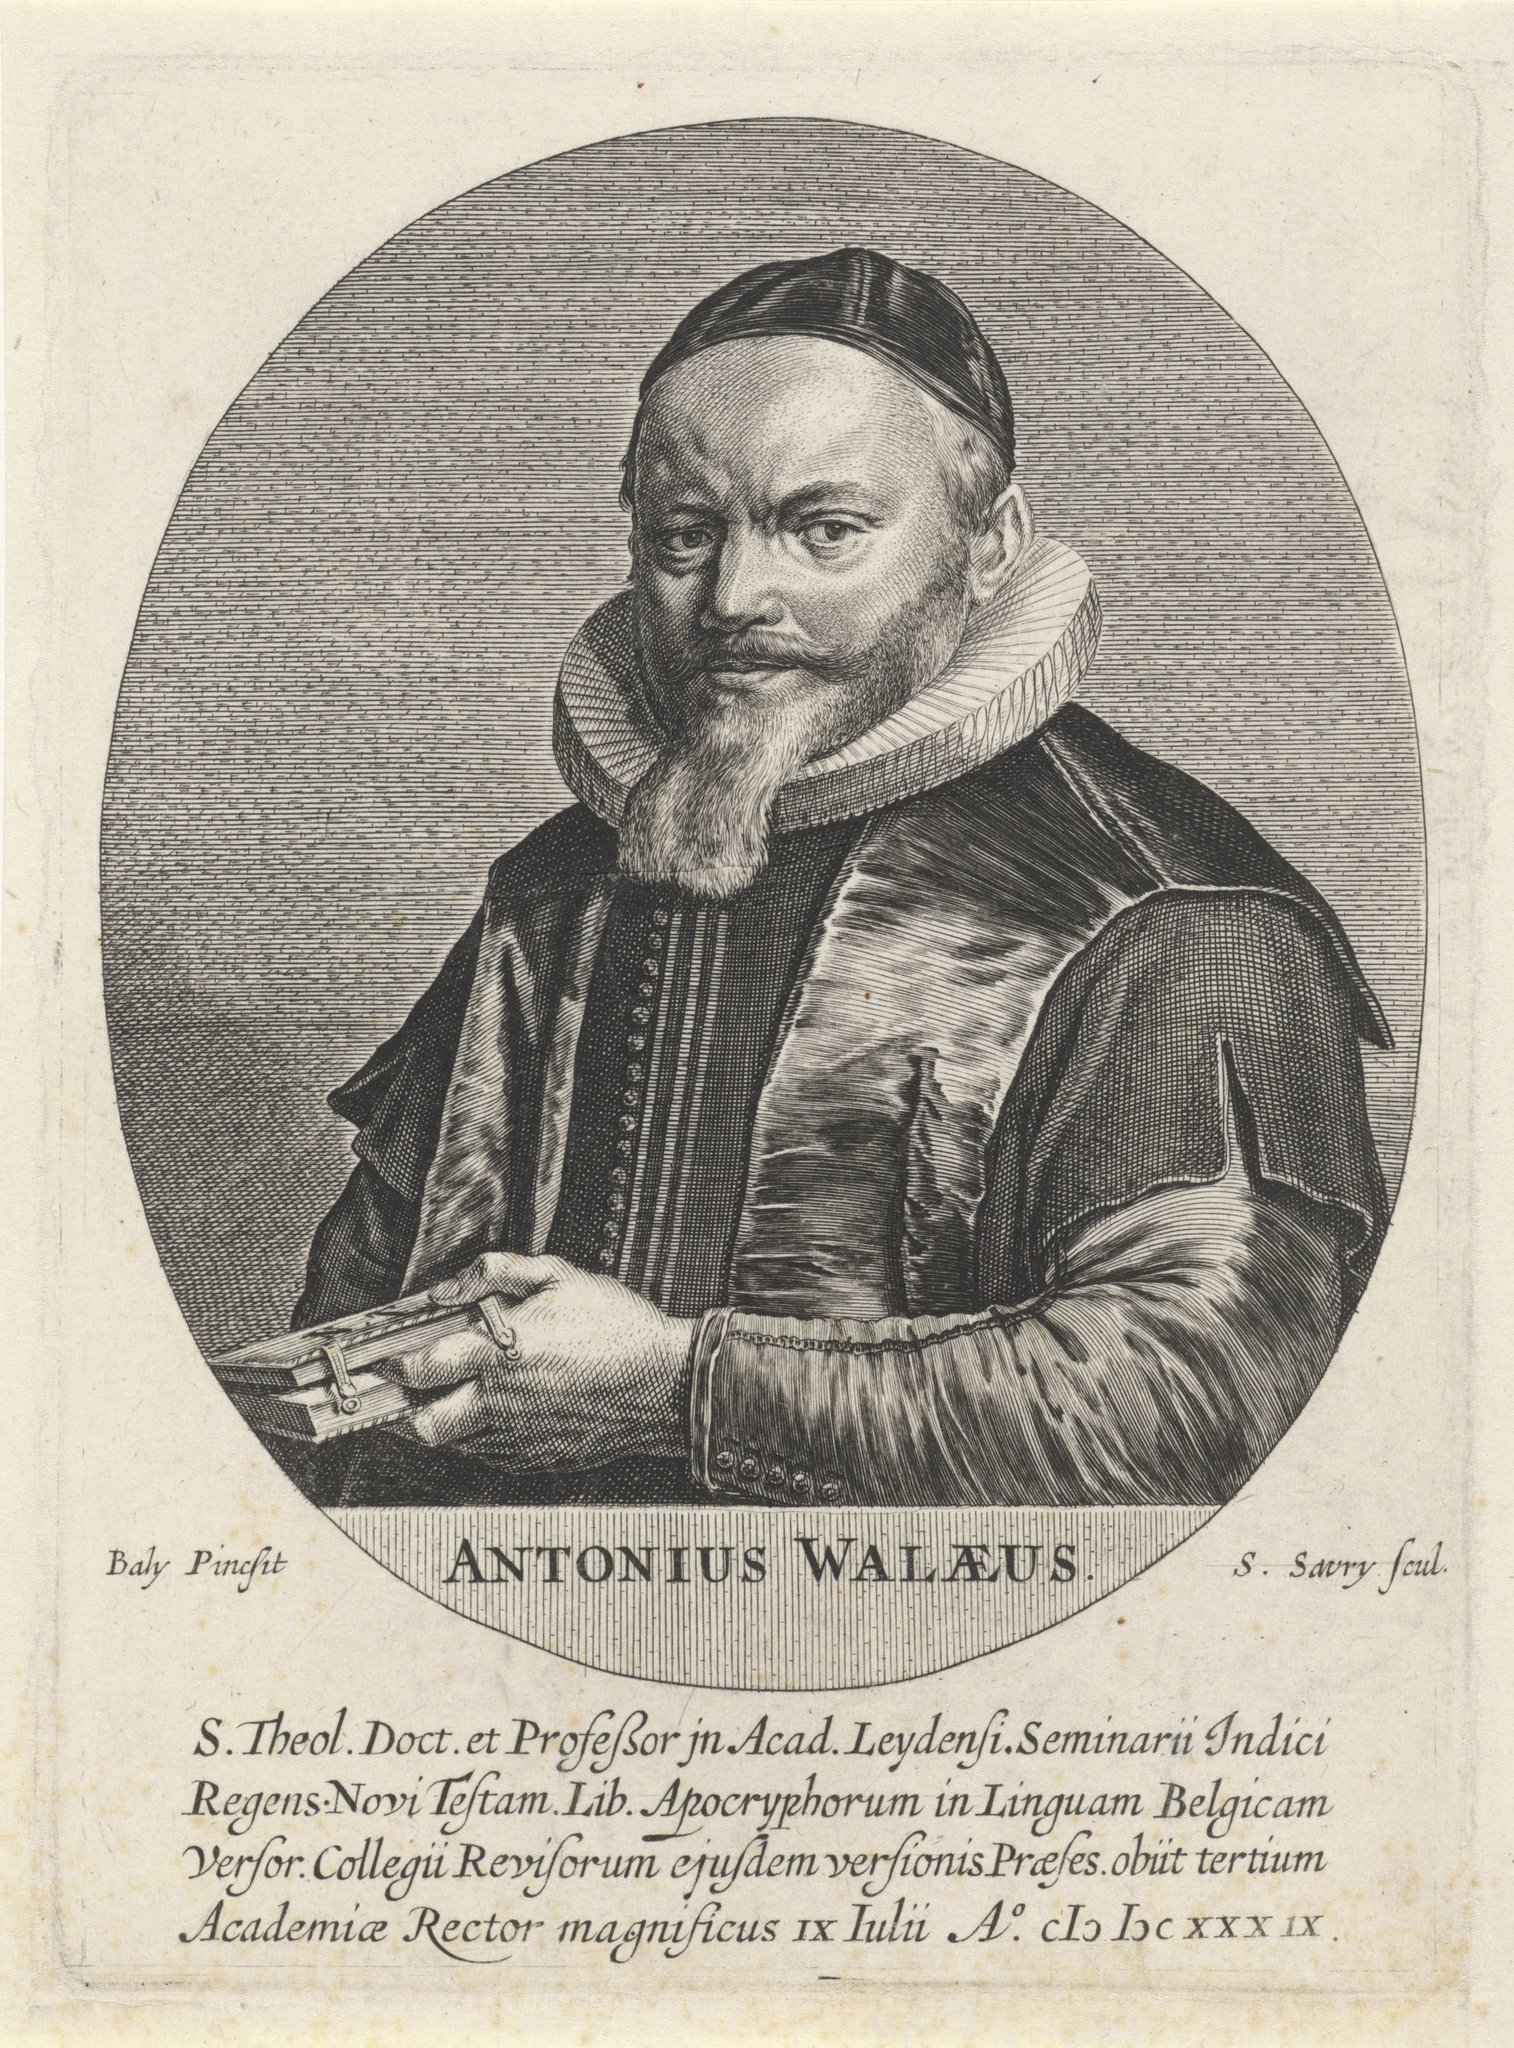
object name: print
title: Portret van Anthony de Wale (Antonius Walaeus), hoogleraar in de theologie te Leiden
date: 1610-1665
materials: paper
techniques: engraving, etching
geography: amsterdam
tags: ghent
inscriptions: collector's mark: Lugt 240